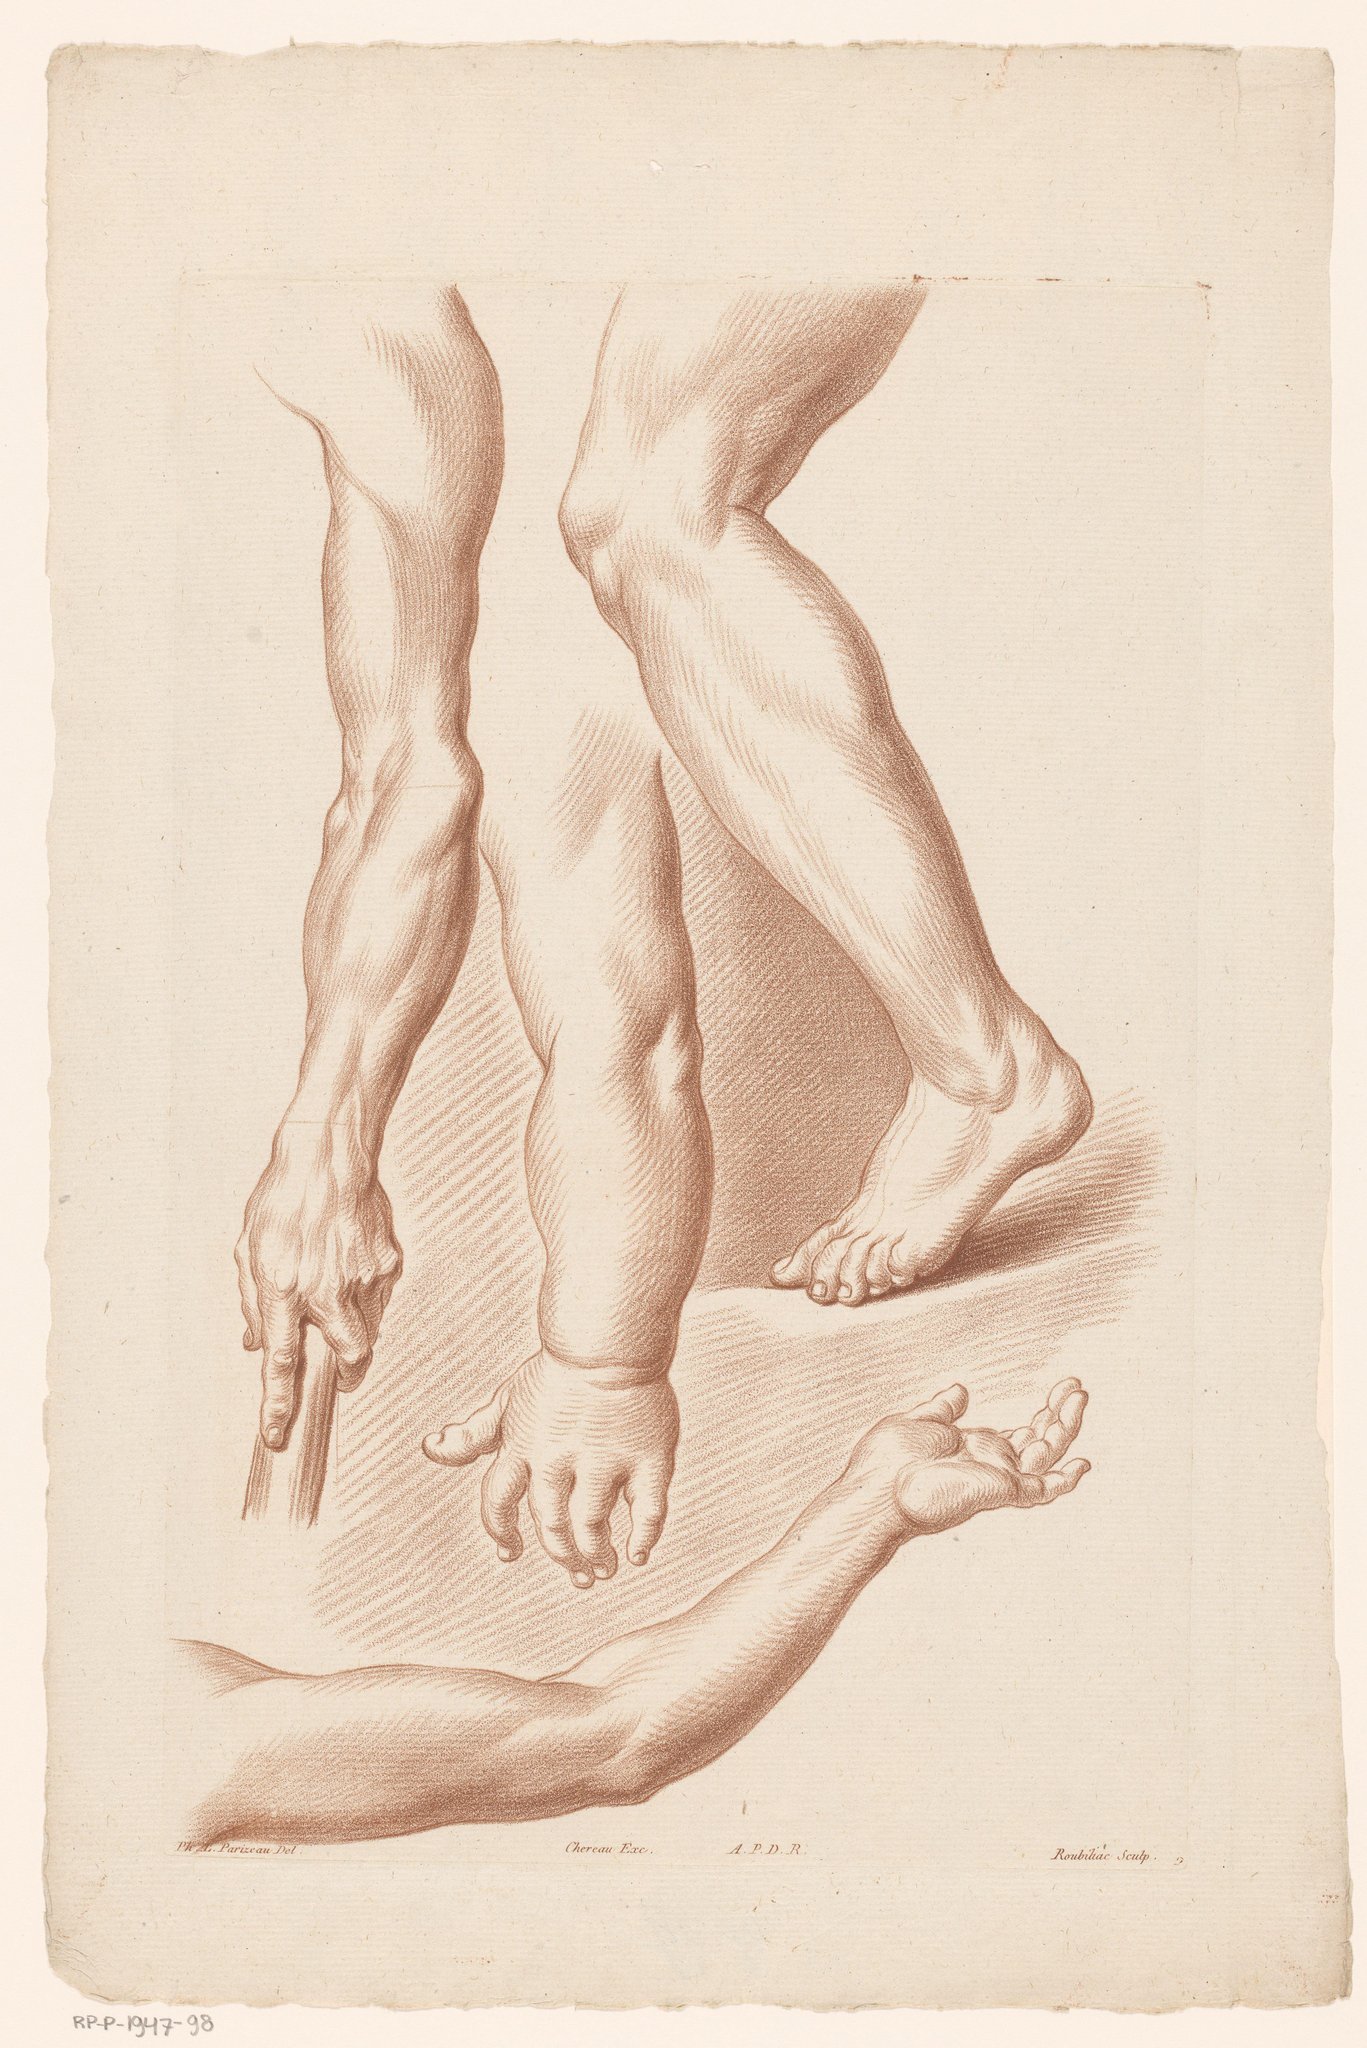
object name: print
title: Compositie met armen en benen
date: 1780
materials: paper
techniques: printmaking, etching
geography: france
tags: drawing, sketch, arms, legs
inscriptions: collector's mark: Lugt 2228